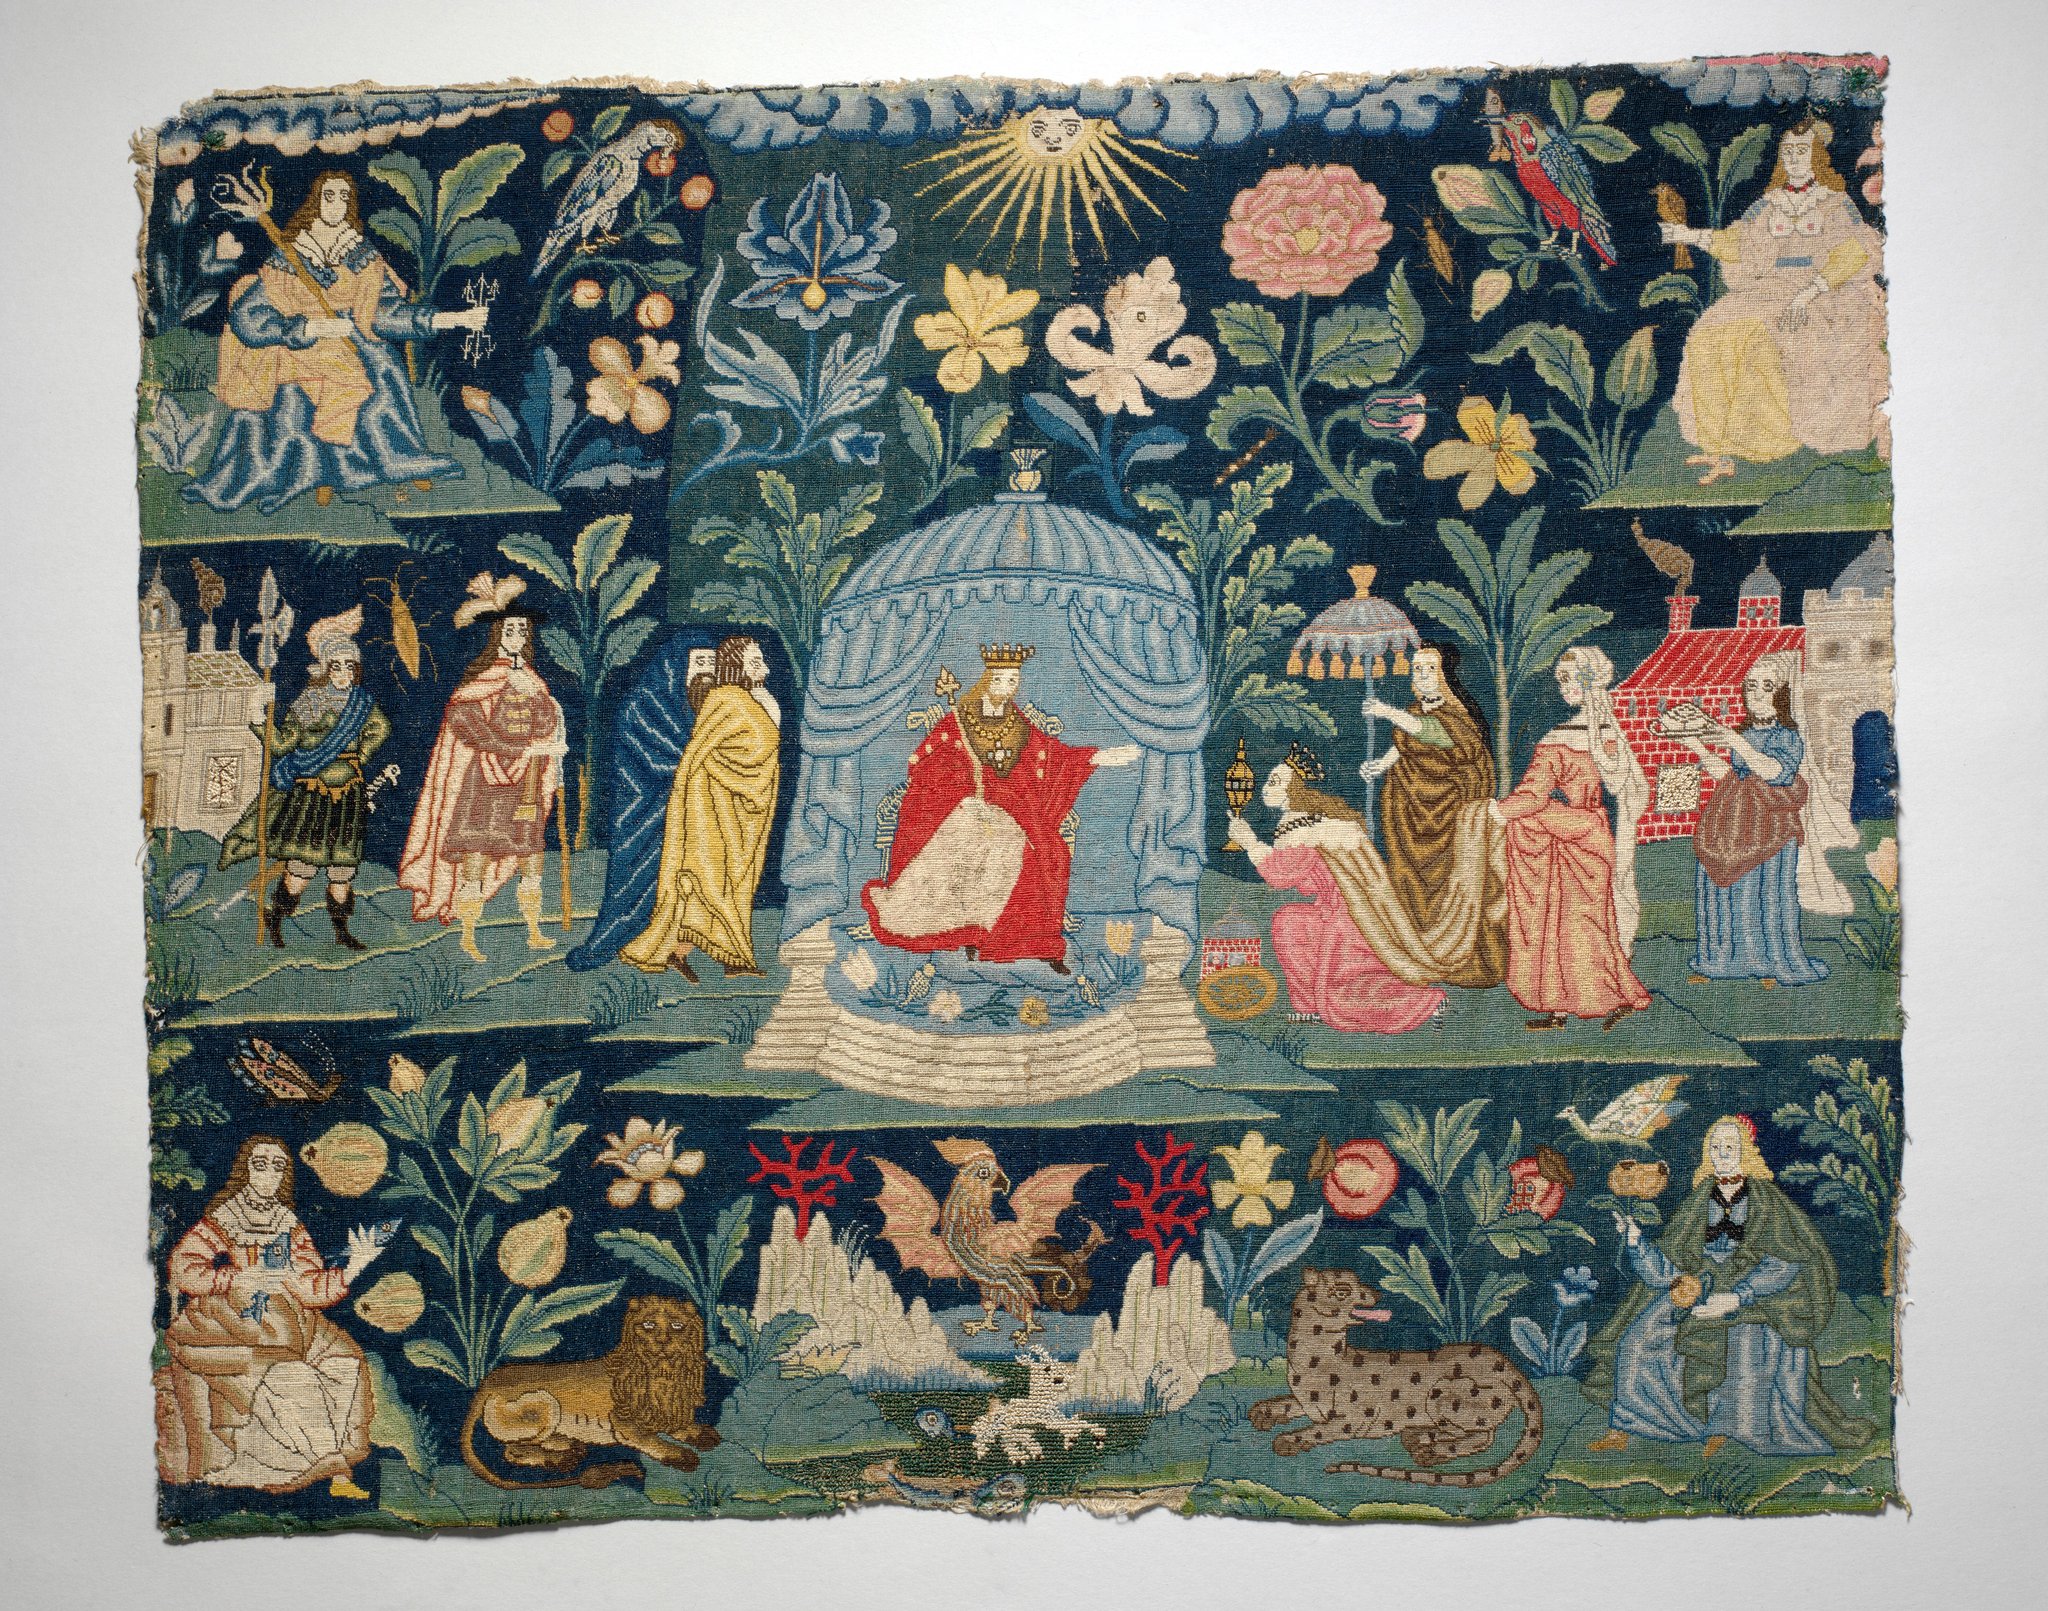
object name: embroidered picture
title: The Meeting of King Solomon and the Queen of Sheba, with the Four Elements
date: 1700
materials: canvas, mica, silk, thread, wool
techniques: embroidery, stitching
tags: animals,birds,kings,queens,men,women,leopards,lions,flowers